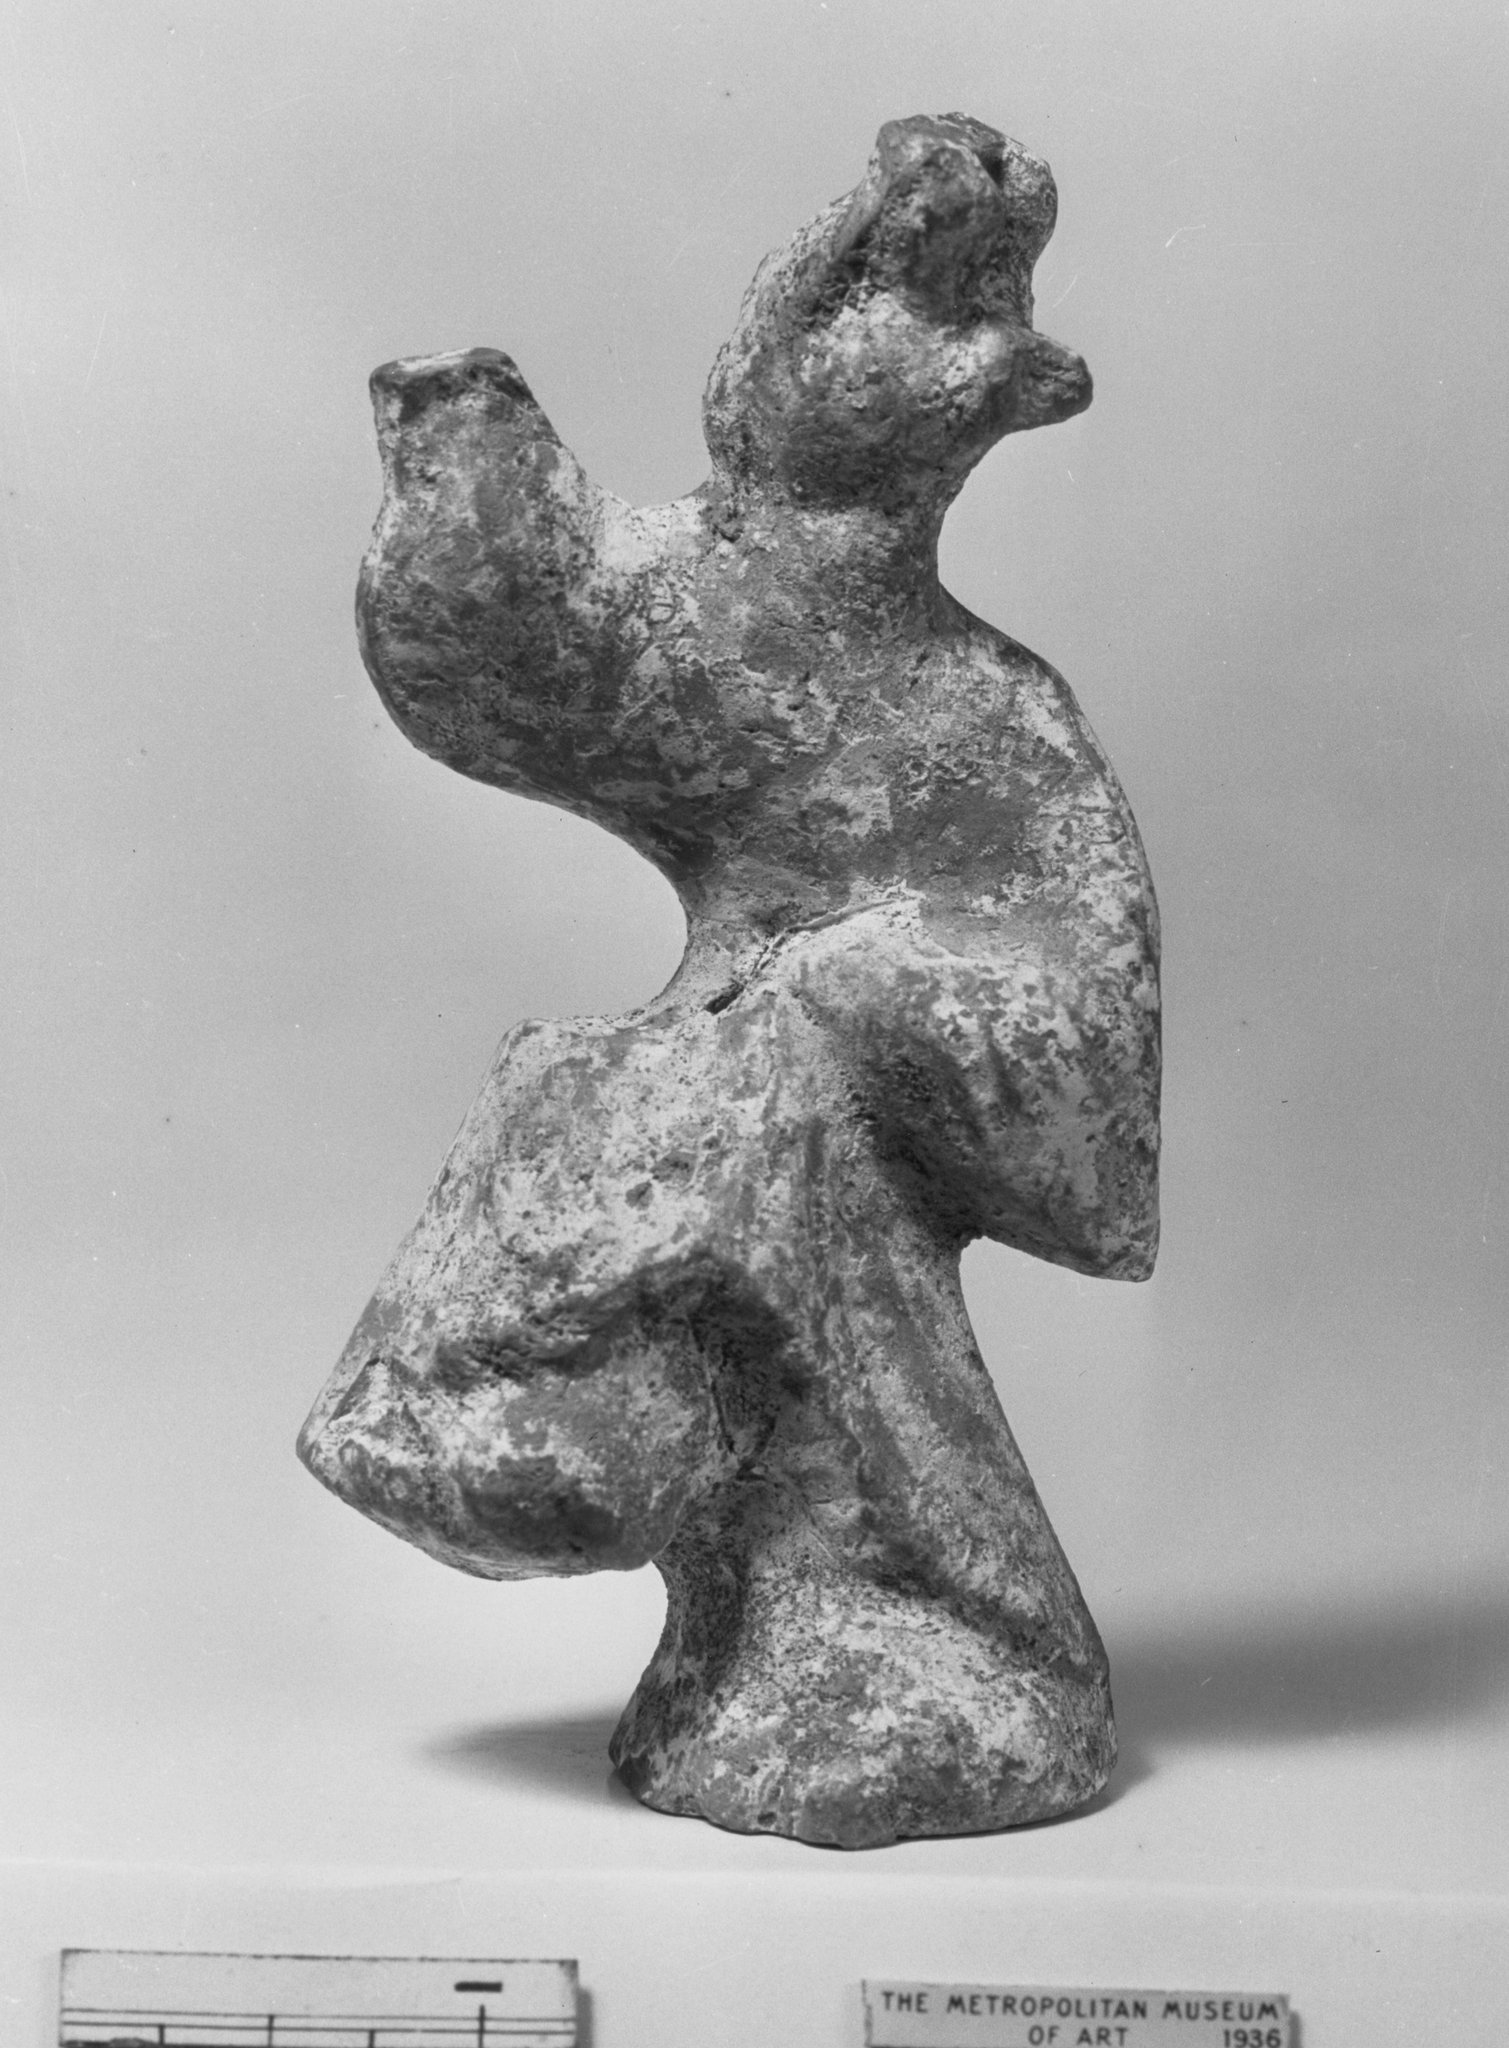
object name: figure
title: Figure of a Dancer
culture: chinese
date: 206 BCE-220 CE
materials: pottery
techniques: polychrome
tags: dancers